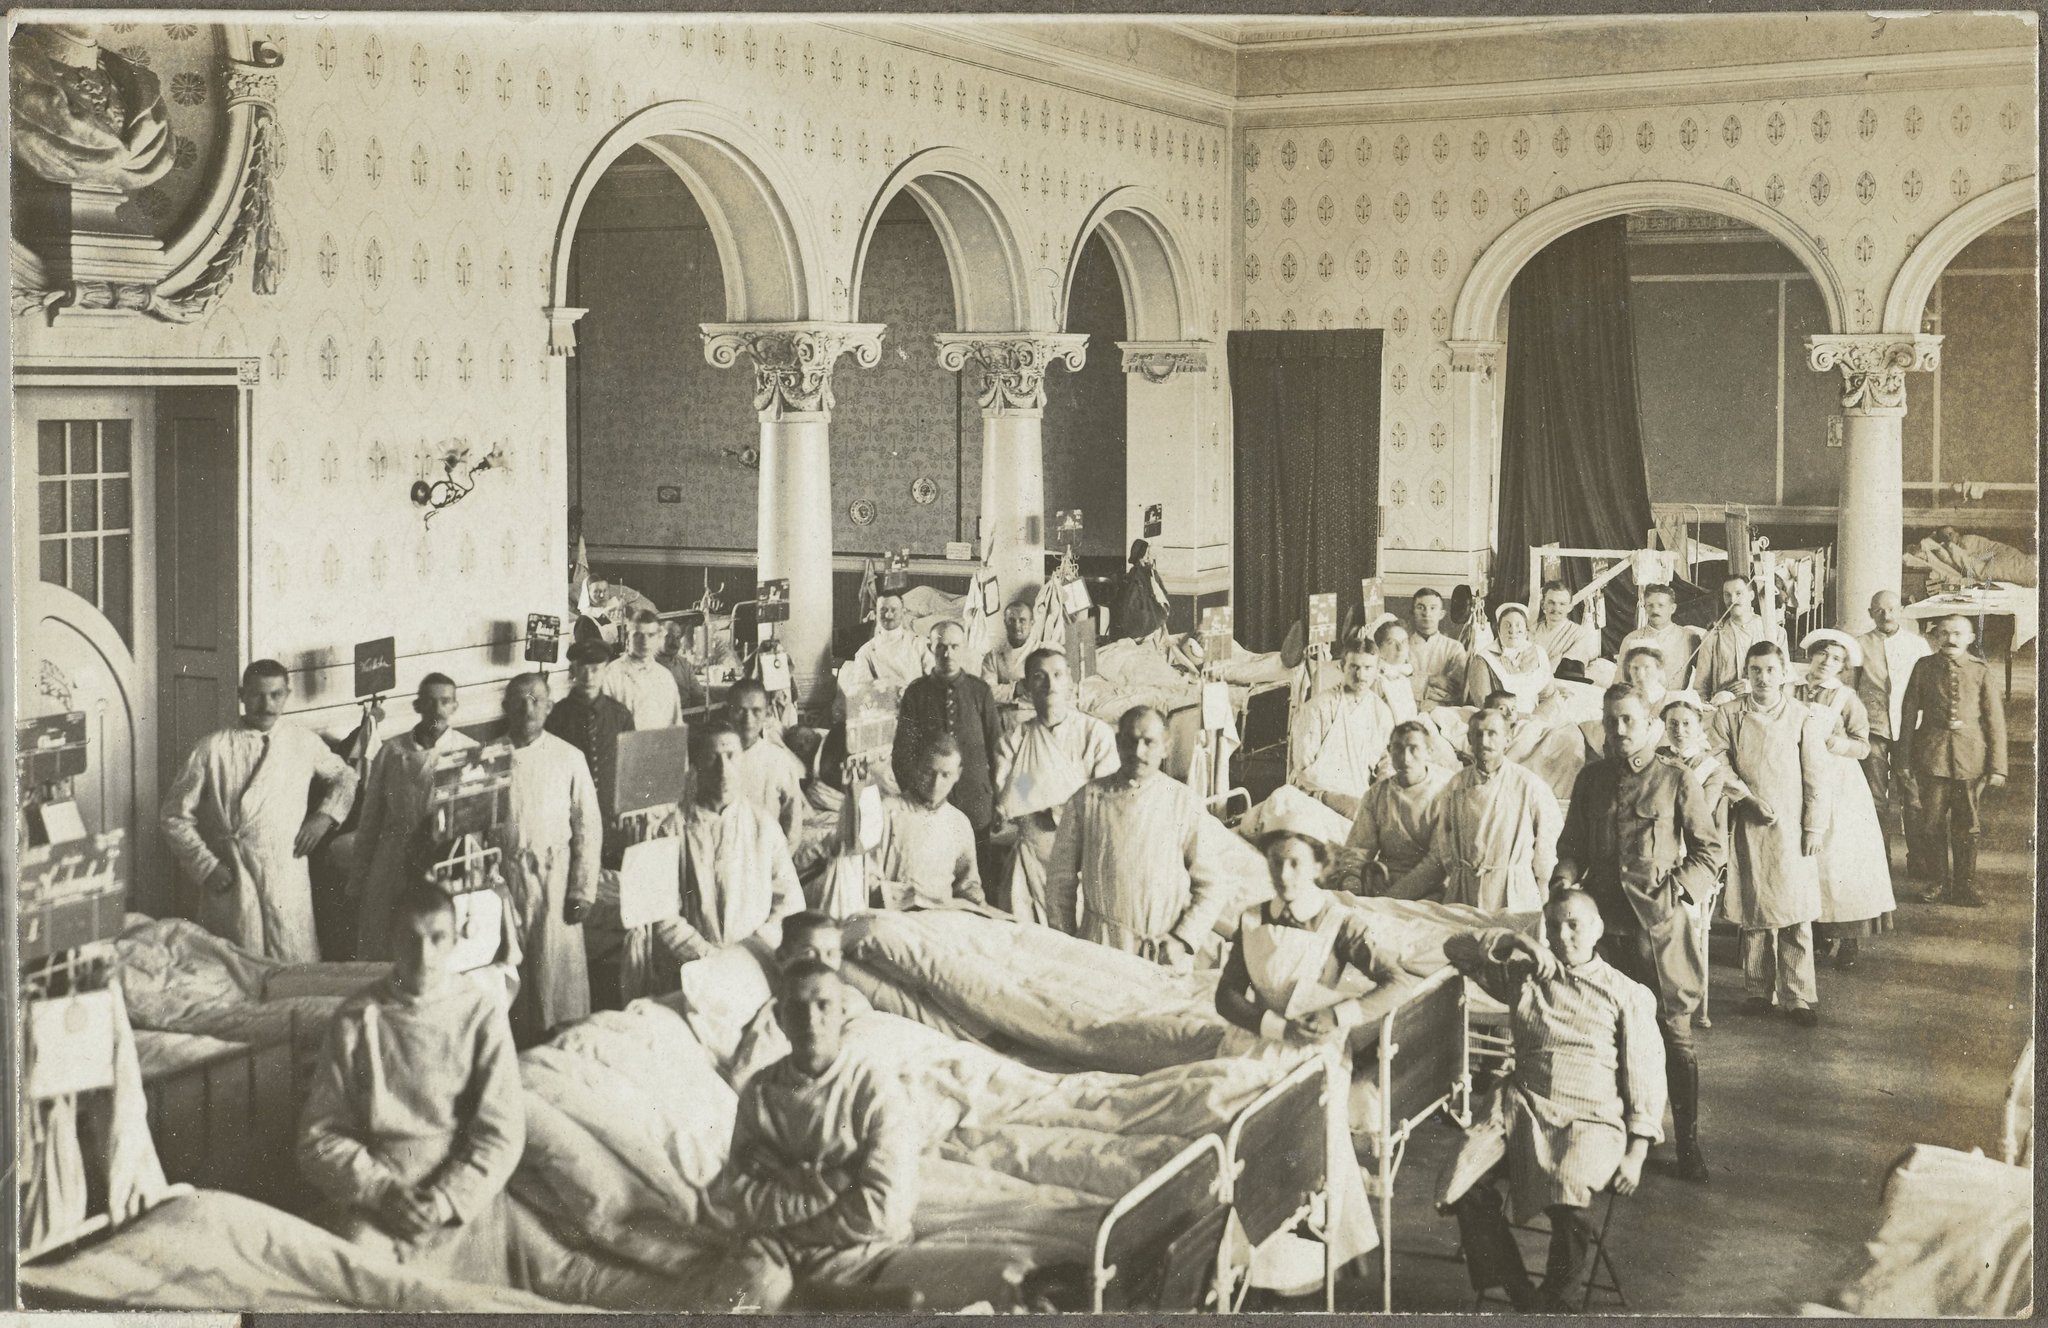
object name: photograph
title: Ziekenzaal van een militair hospitaal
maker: Anonymous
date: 1912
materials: photographic support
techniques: albumen print